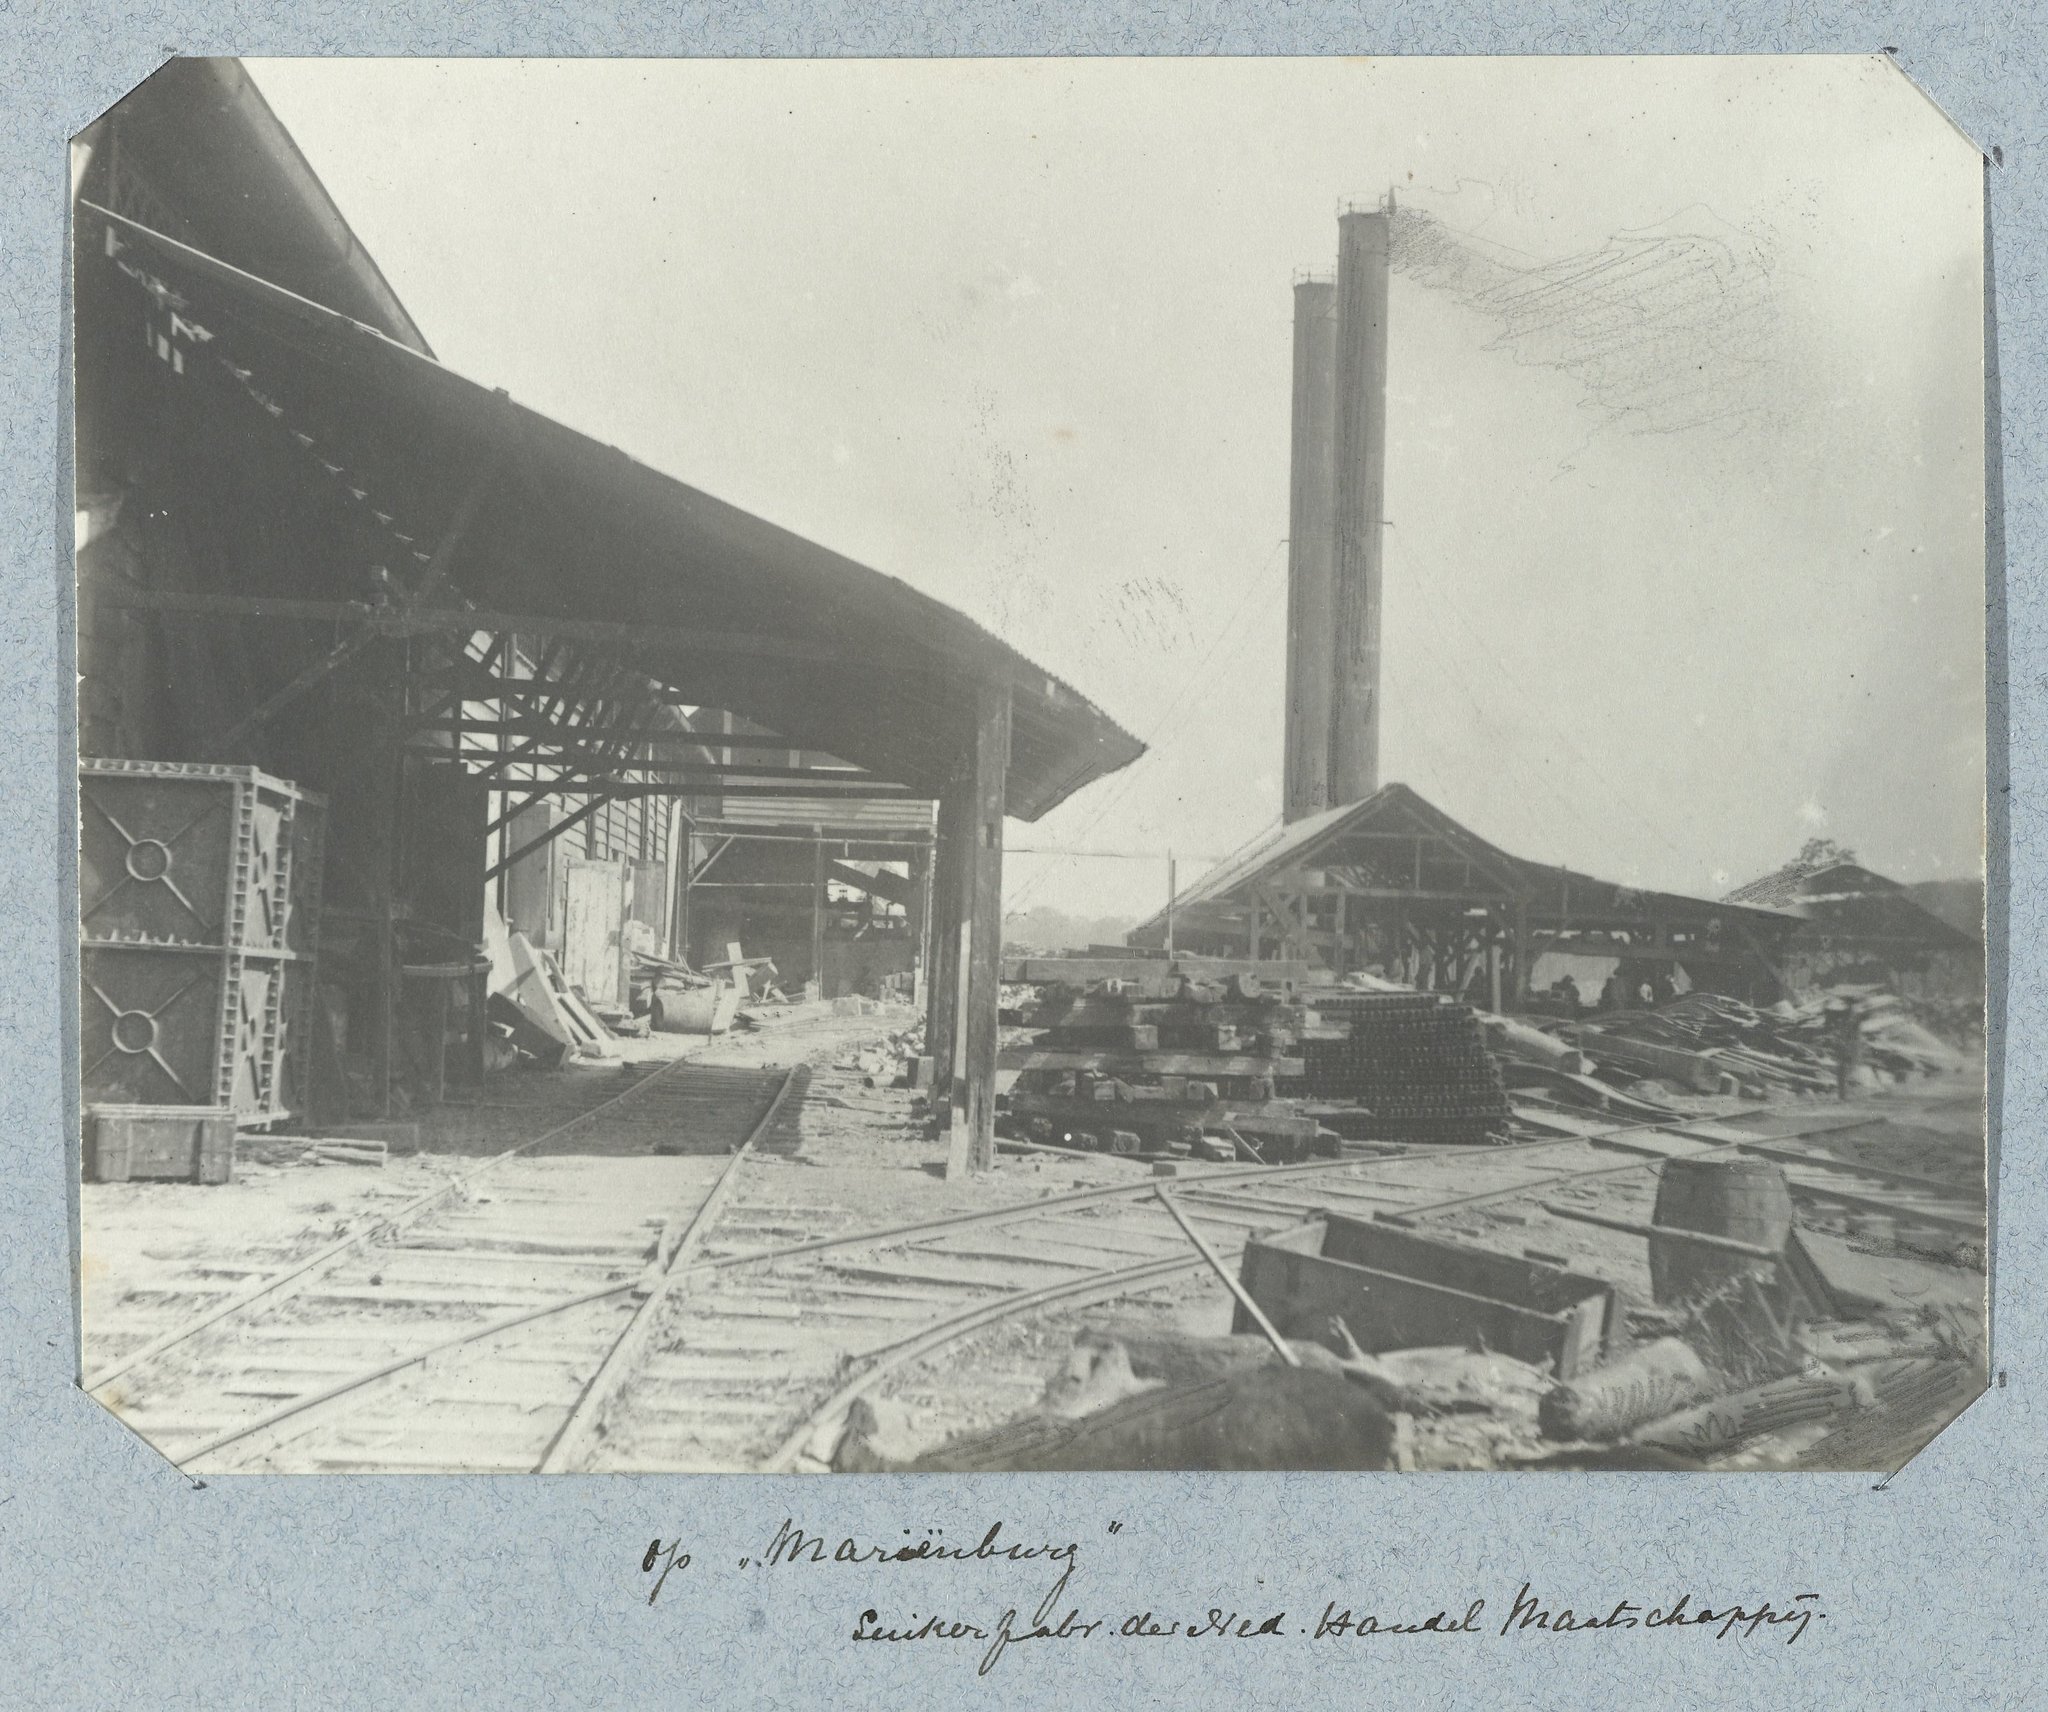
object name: photograph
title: Op "Mariënburg" / Suikerfabriek der Ned. Handel Maatschappij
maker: théodore van lelyveld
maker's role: painter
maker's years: 1867-1954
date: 1895-1898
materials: photographic support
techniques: gelatin silver print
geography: suriname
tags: plantation, factory-building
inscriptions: inscription: ‘Op "Mariënburg" / Suikerfabriek der Ned. Handel Maatschappij.’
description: De suikerfabriek van de Nederlandse Handelsmaatschappij te Mariënburg. Loodsen, spoorbaan en rokende schoorstenen. Fotoafdruk in een fotoalbum van Théodore van Lelyveld over Suriname uit 1895-1898.